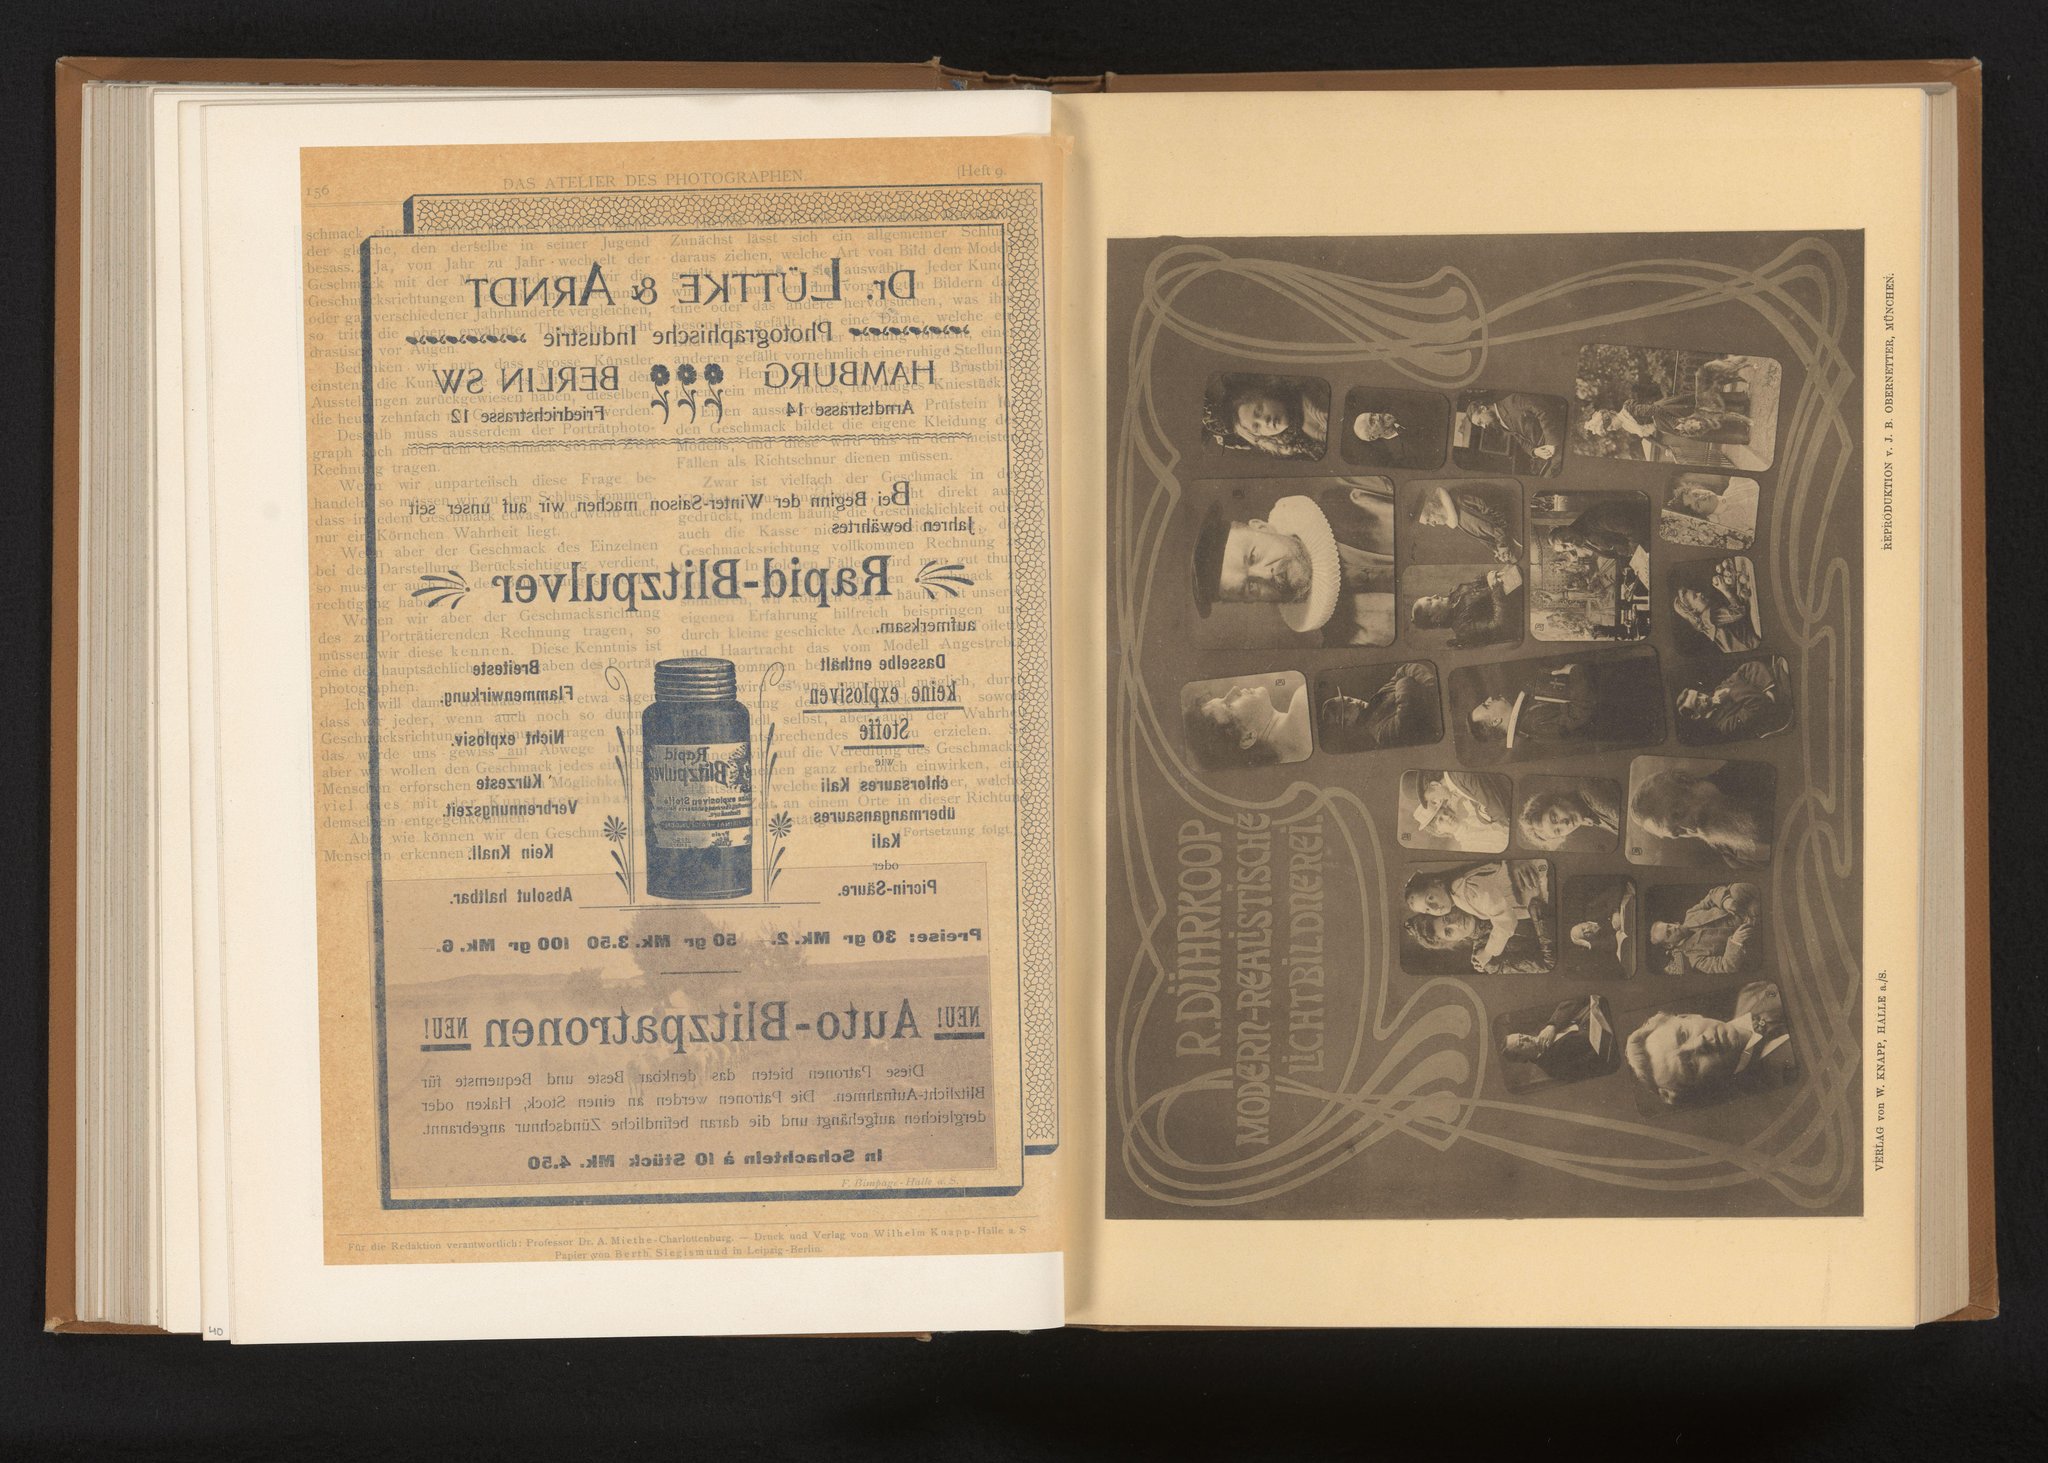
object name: photomechanical print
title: Collage van portretten van onbekende mannen, vrouwen en kinderen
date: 1895-1900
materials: paper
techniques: photograph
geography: halle an der saale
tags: historical persons - bb - woman, child, historical persons